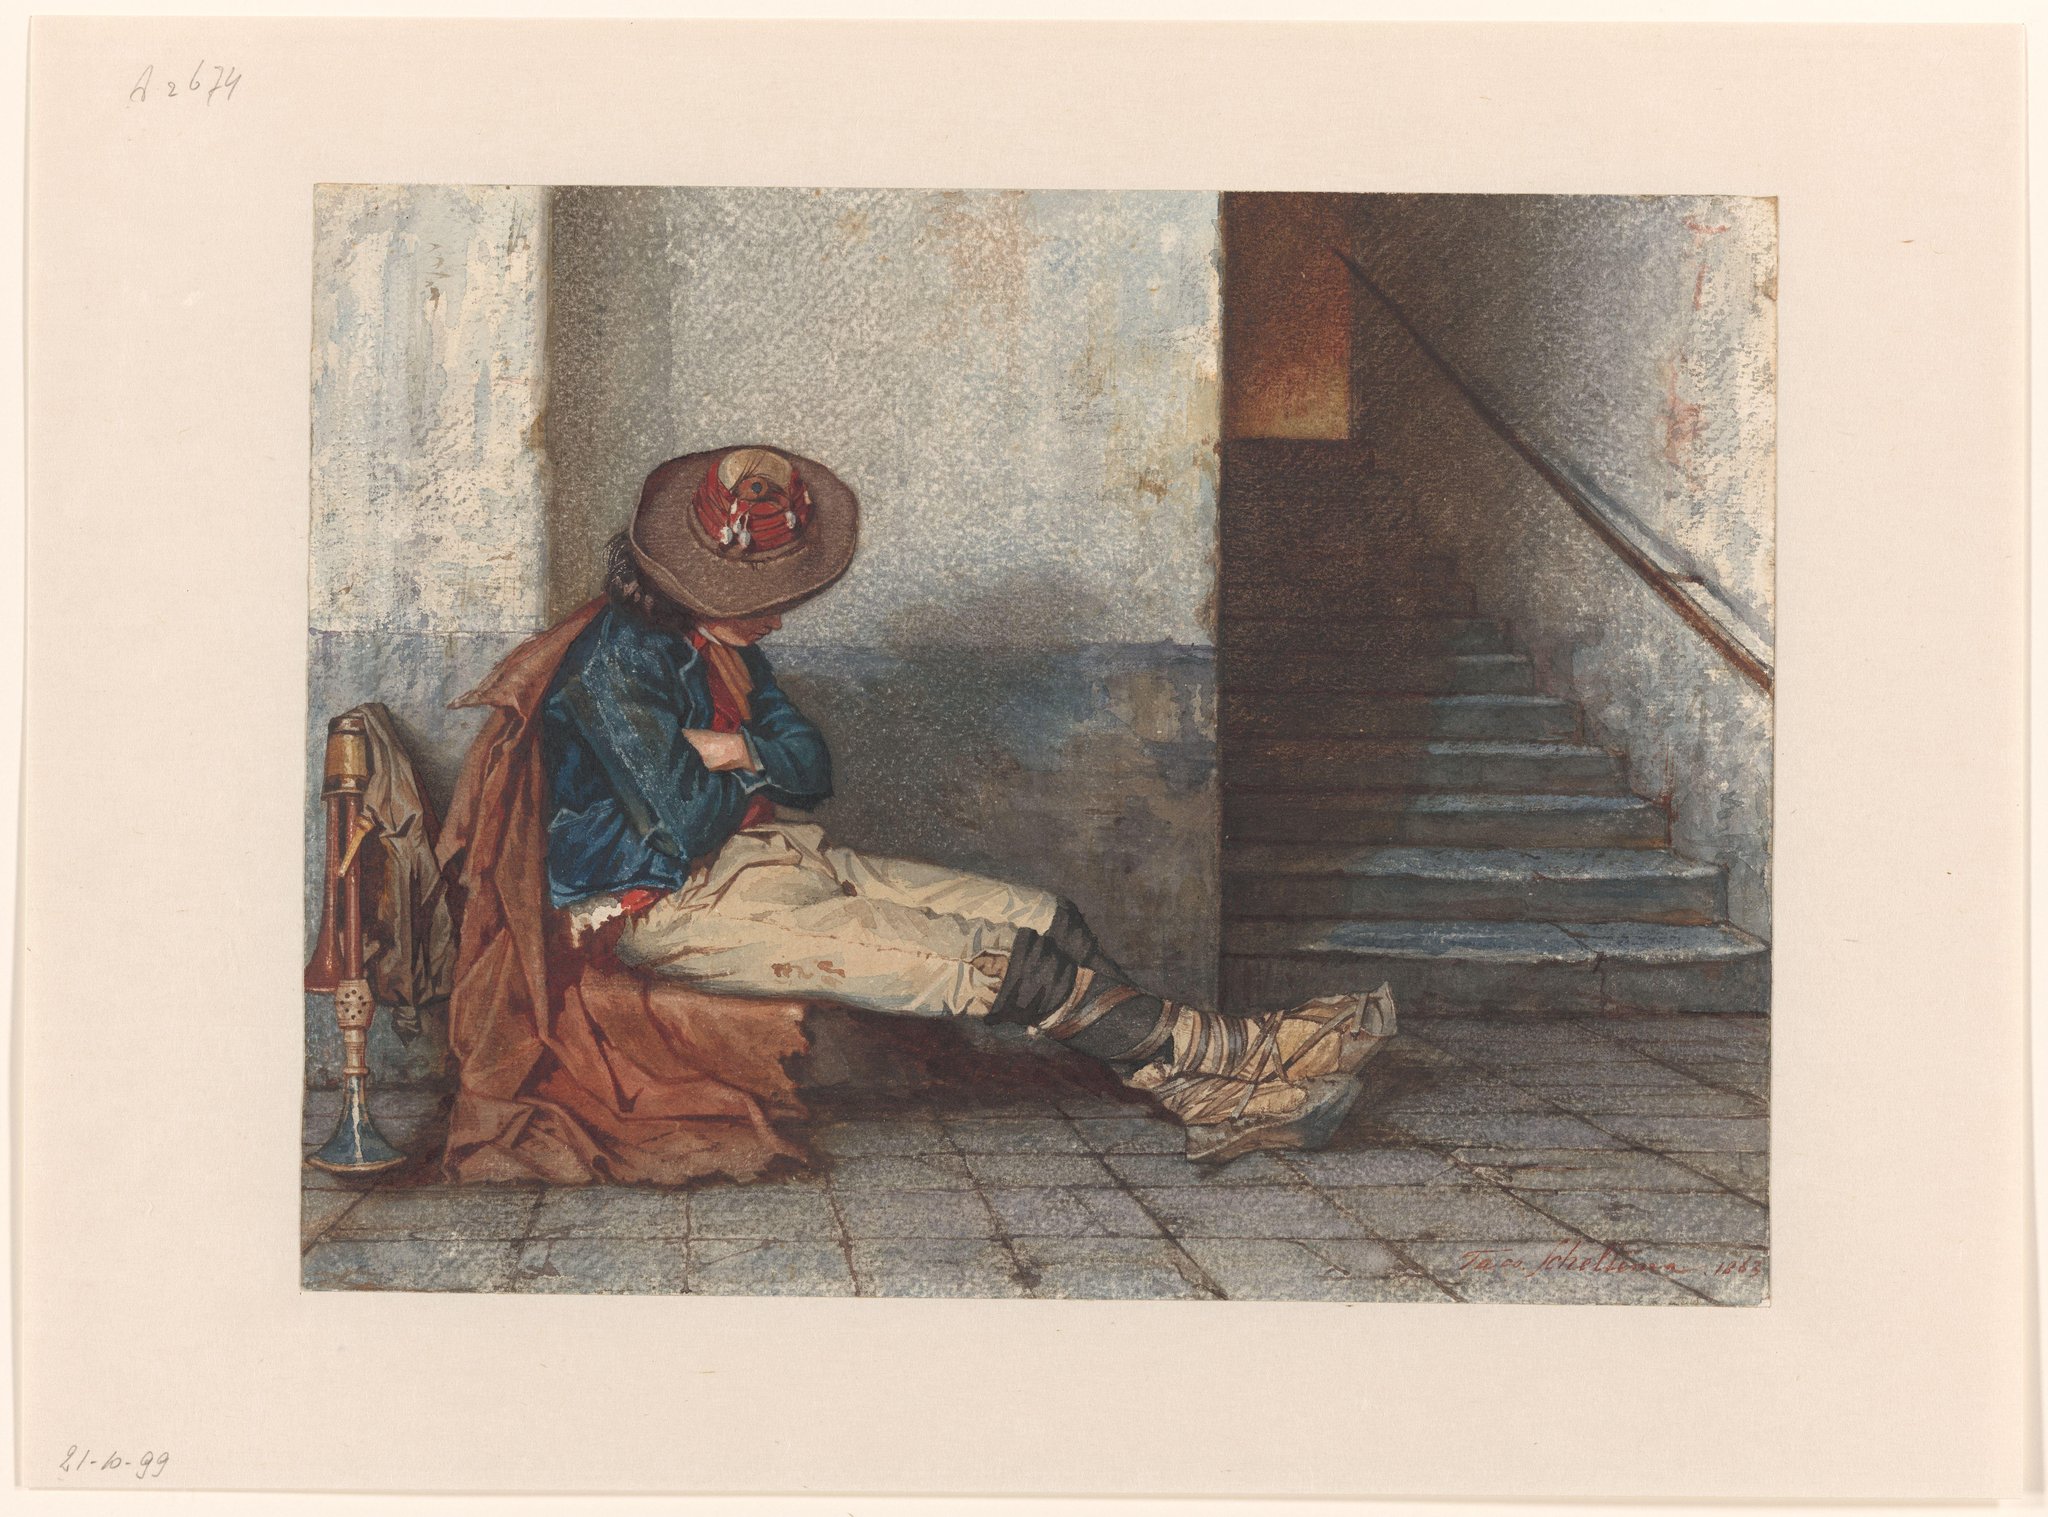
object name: watercolor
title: Slapende Pifferaro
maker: taco jan scheltema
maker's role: draughtsman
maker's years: 1831-1867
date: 1863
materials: paper, watercolor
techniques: brush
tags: bagpipe, musette, one person with musical instrument, not playing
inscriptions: date: ‘1863’